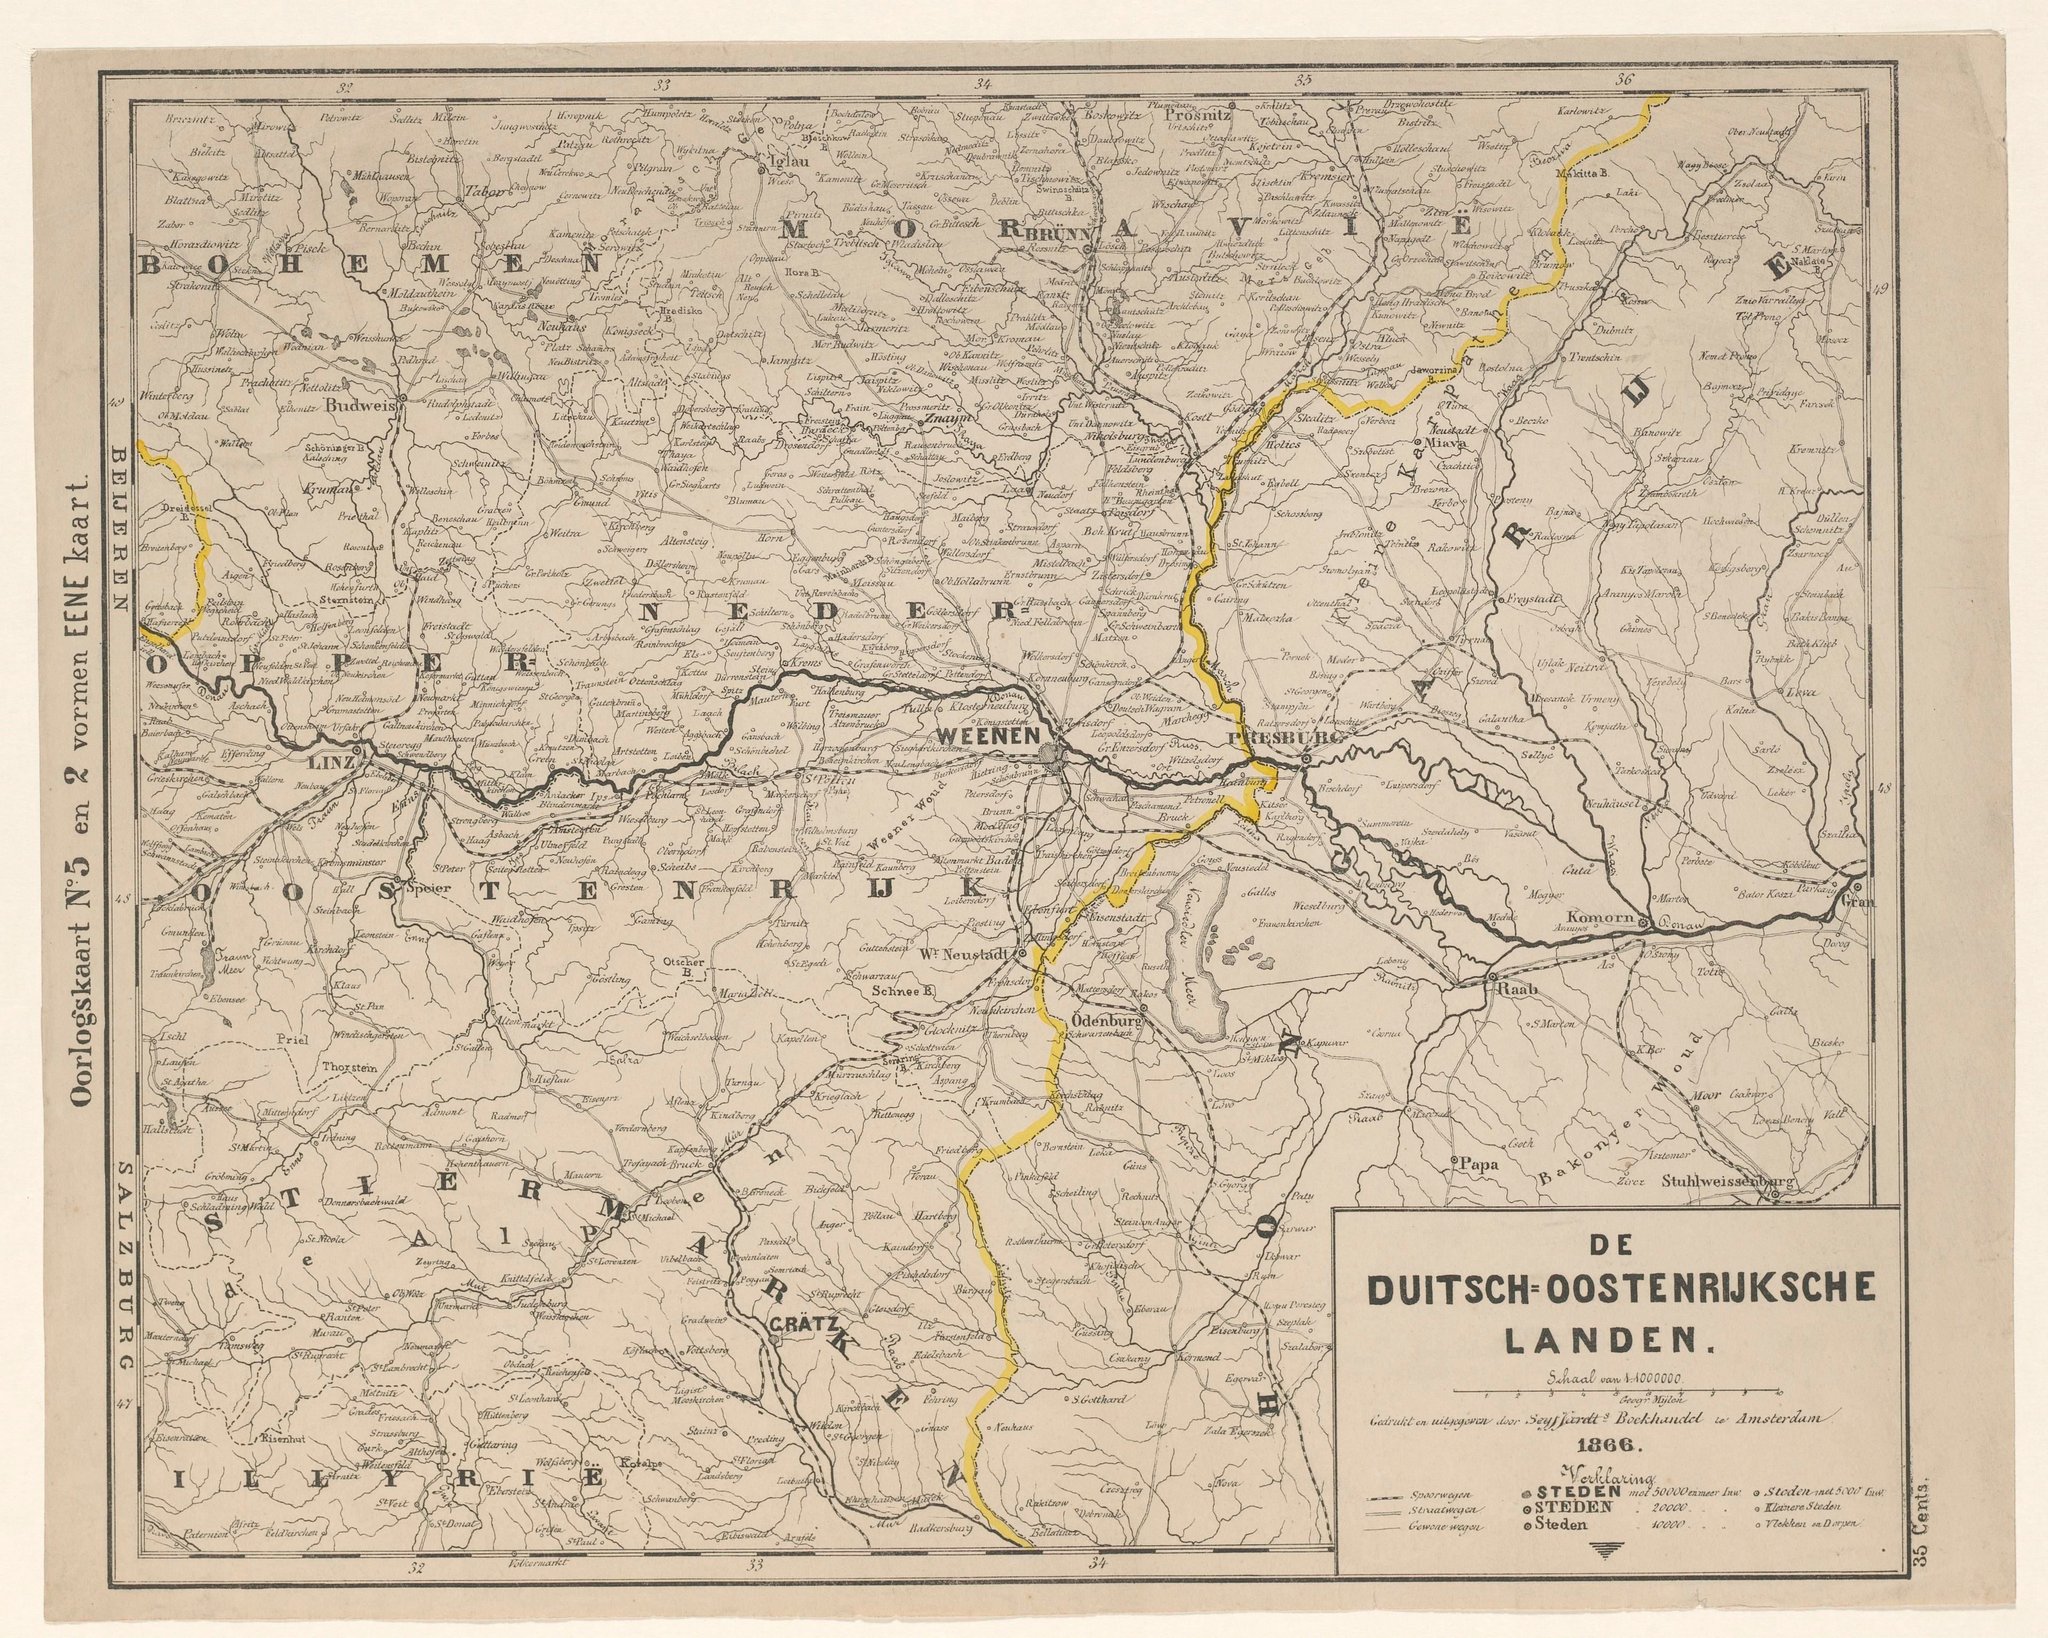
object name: map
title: De Duitsch-Oostenrijksche landen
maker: Anonymous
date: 1866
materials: paper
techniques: lithograph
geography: amsterdam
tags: maps of separate countries or regions, austria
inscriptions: date